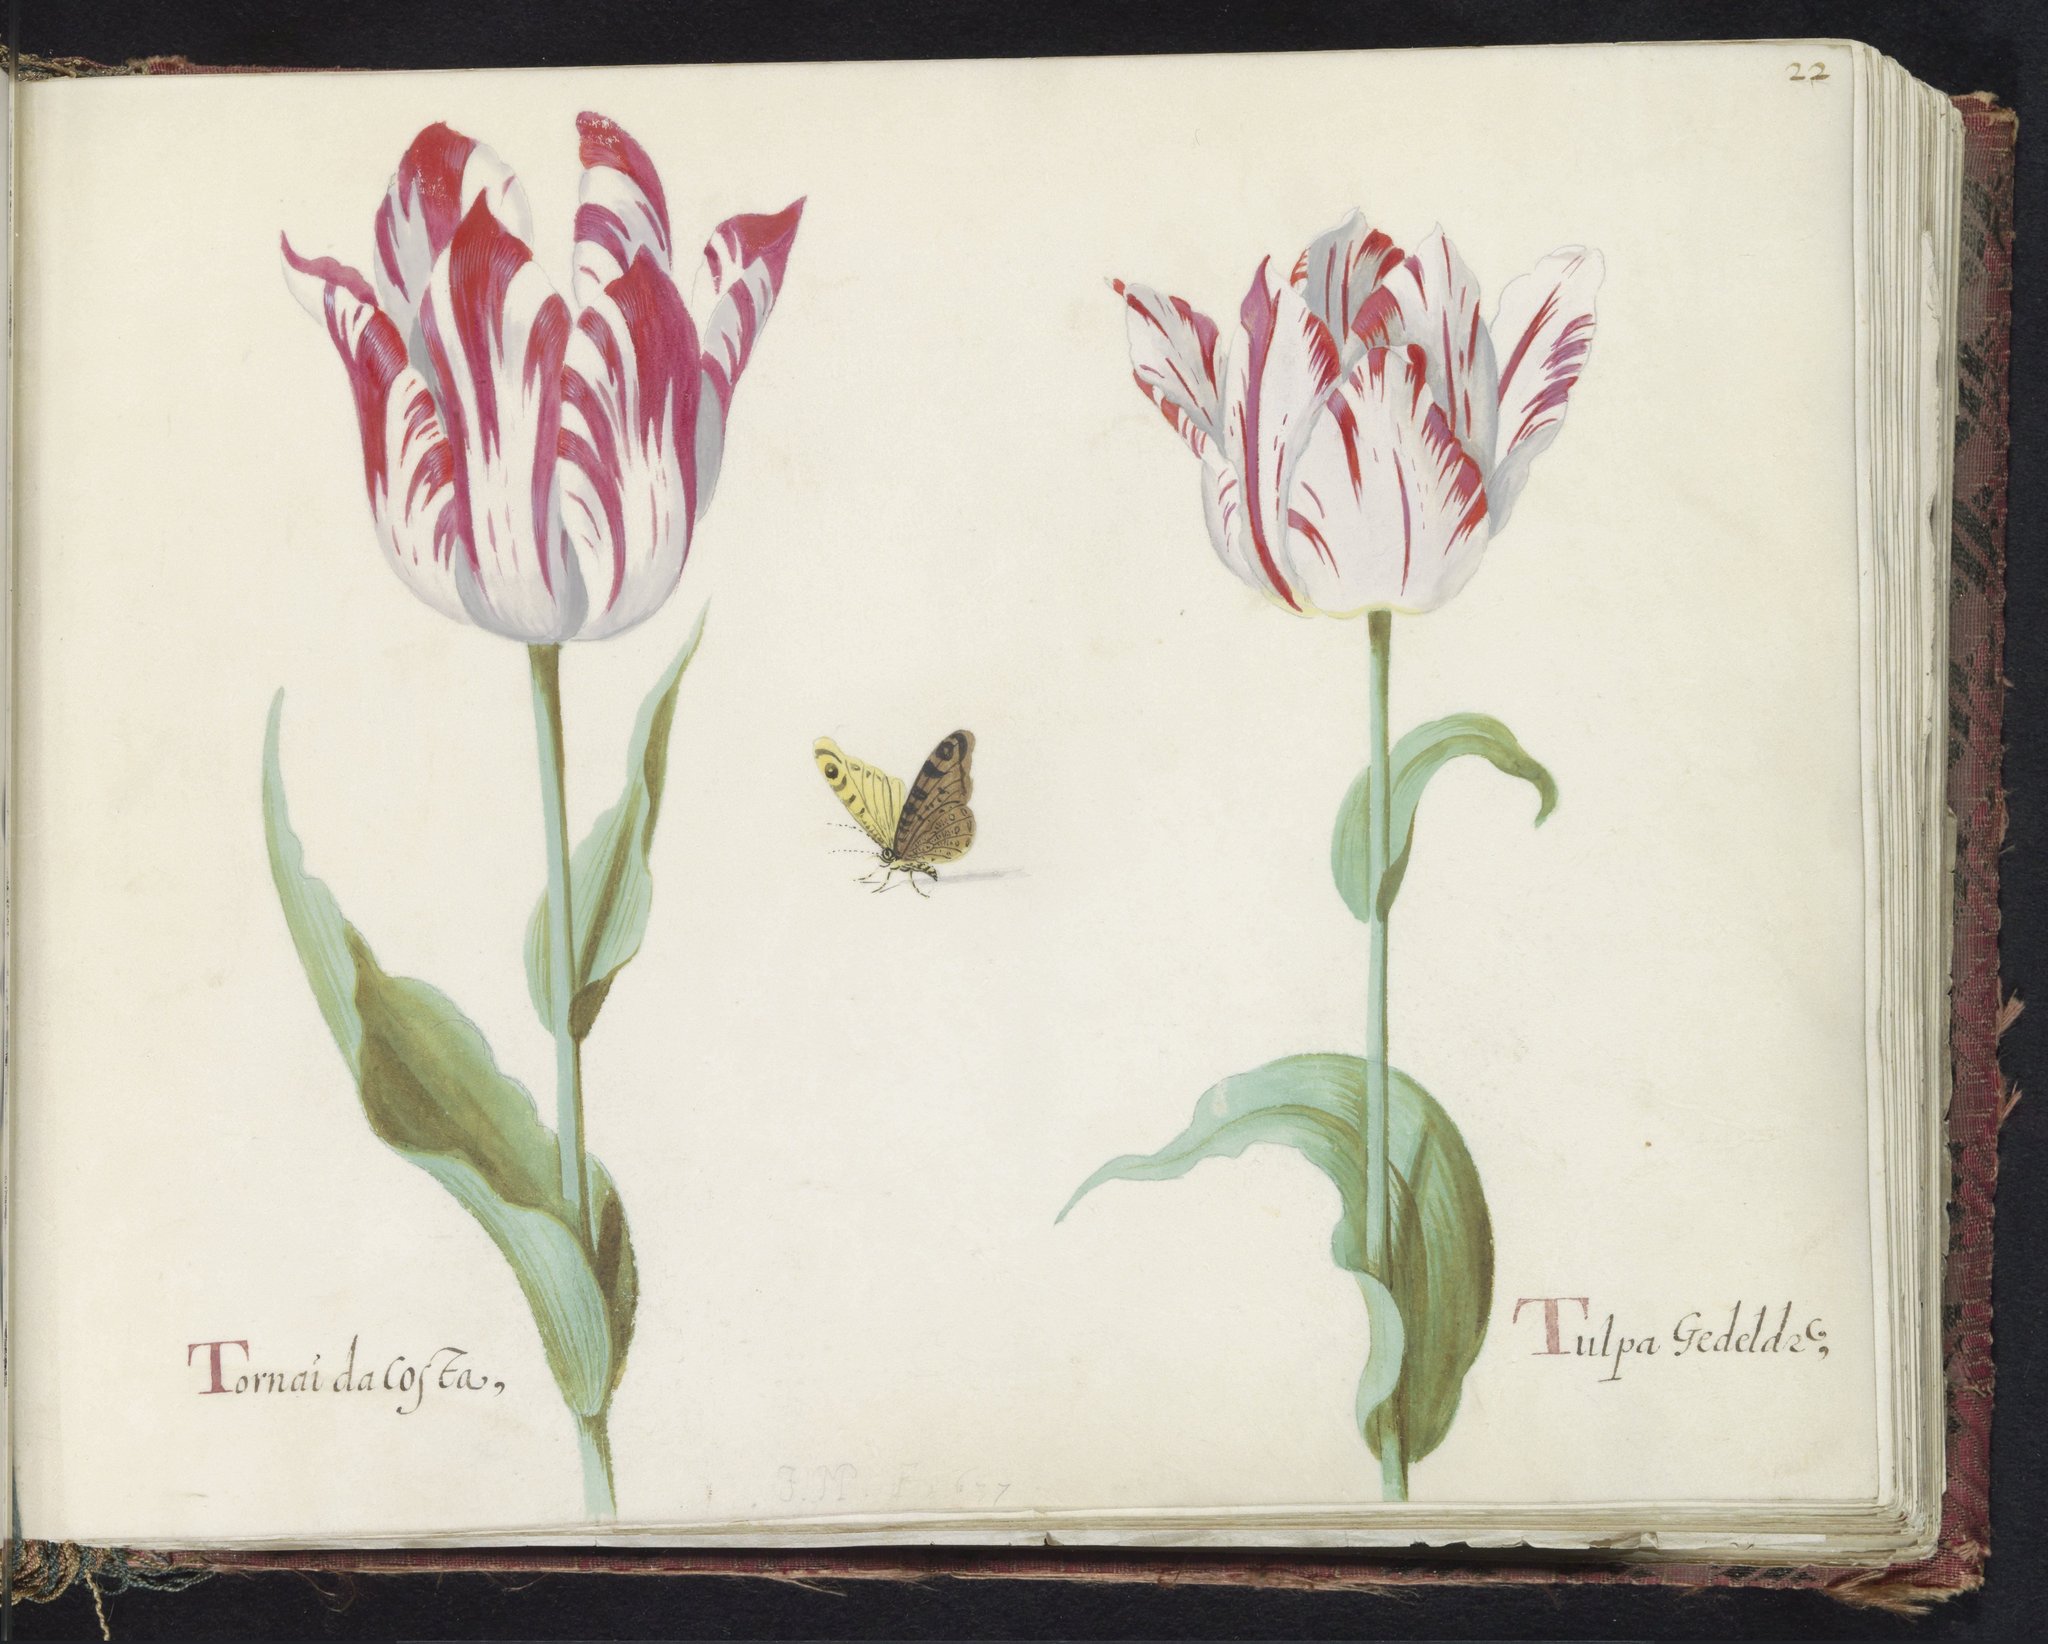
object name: album leaf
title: Tornau da Costa / Tulpa Gedeldr(i)g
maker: jacob marrel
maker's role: draughtsman, painter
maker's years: 1614-1681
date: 1637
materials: paint, parchment, pencil, watercolor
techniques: brush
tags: insects: butterfly, flowers: tulip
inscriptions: date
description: De tekening maakt deel uit van een album.